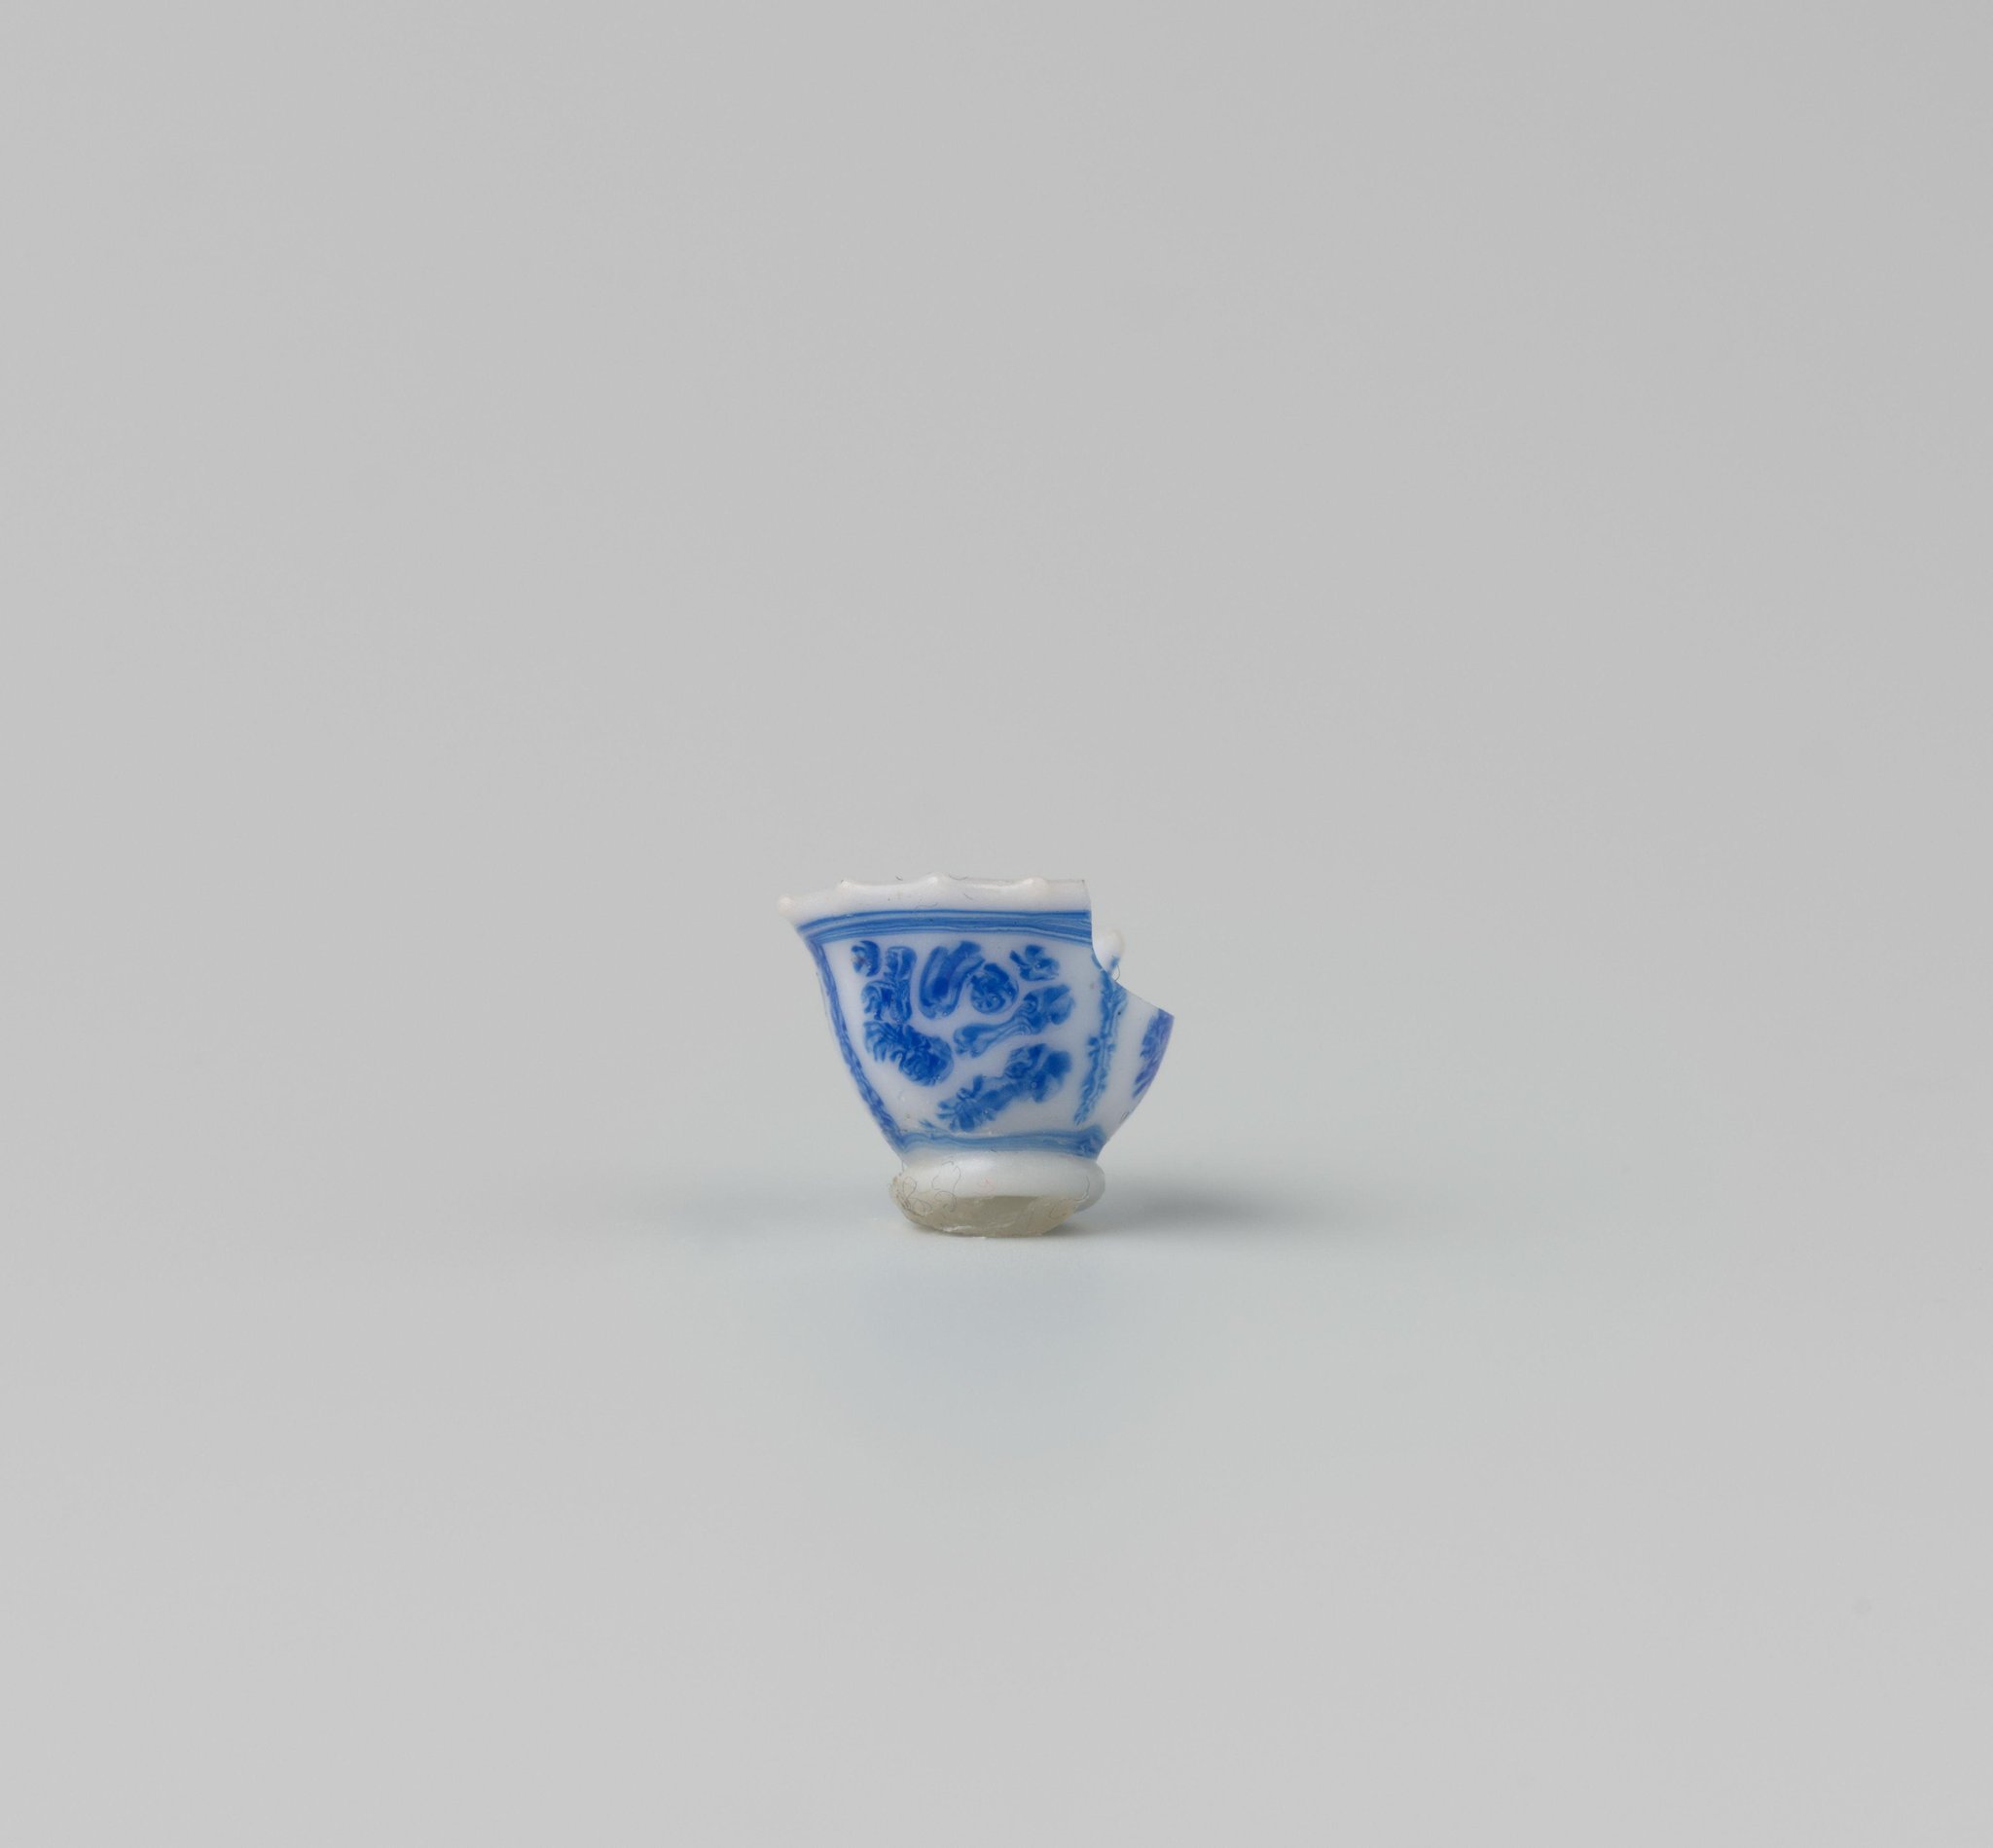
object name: tea cup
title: Theekopje van melkglas met blauwe emailverf beschildering, imitatie Chinees porselein met 'bloem' decoratie in drie vakken; model met puntrand, nauwelijks een standring.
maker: Anonymous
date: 1675-1710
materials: glass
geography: amsterdam